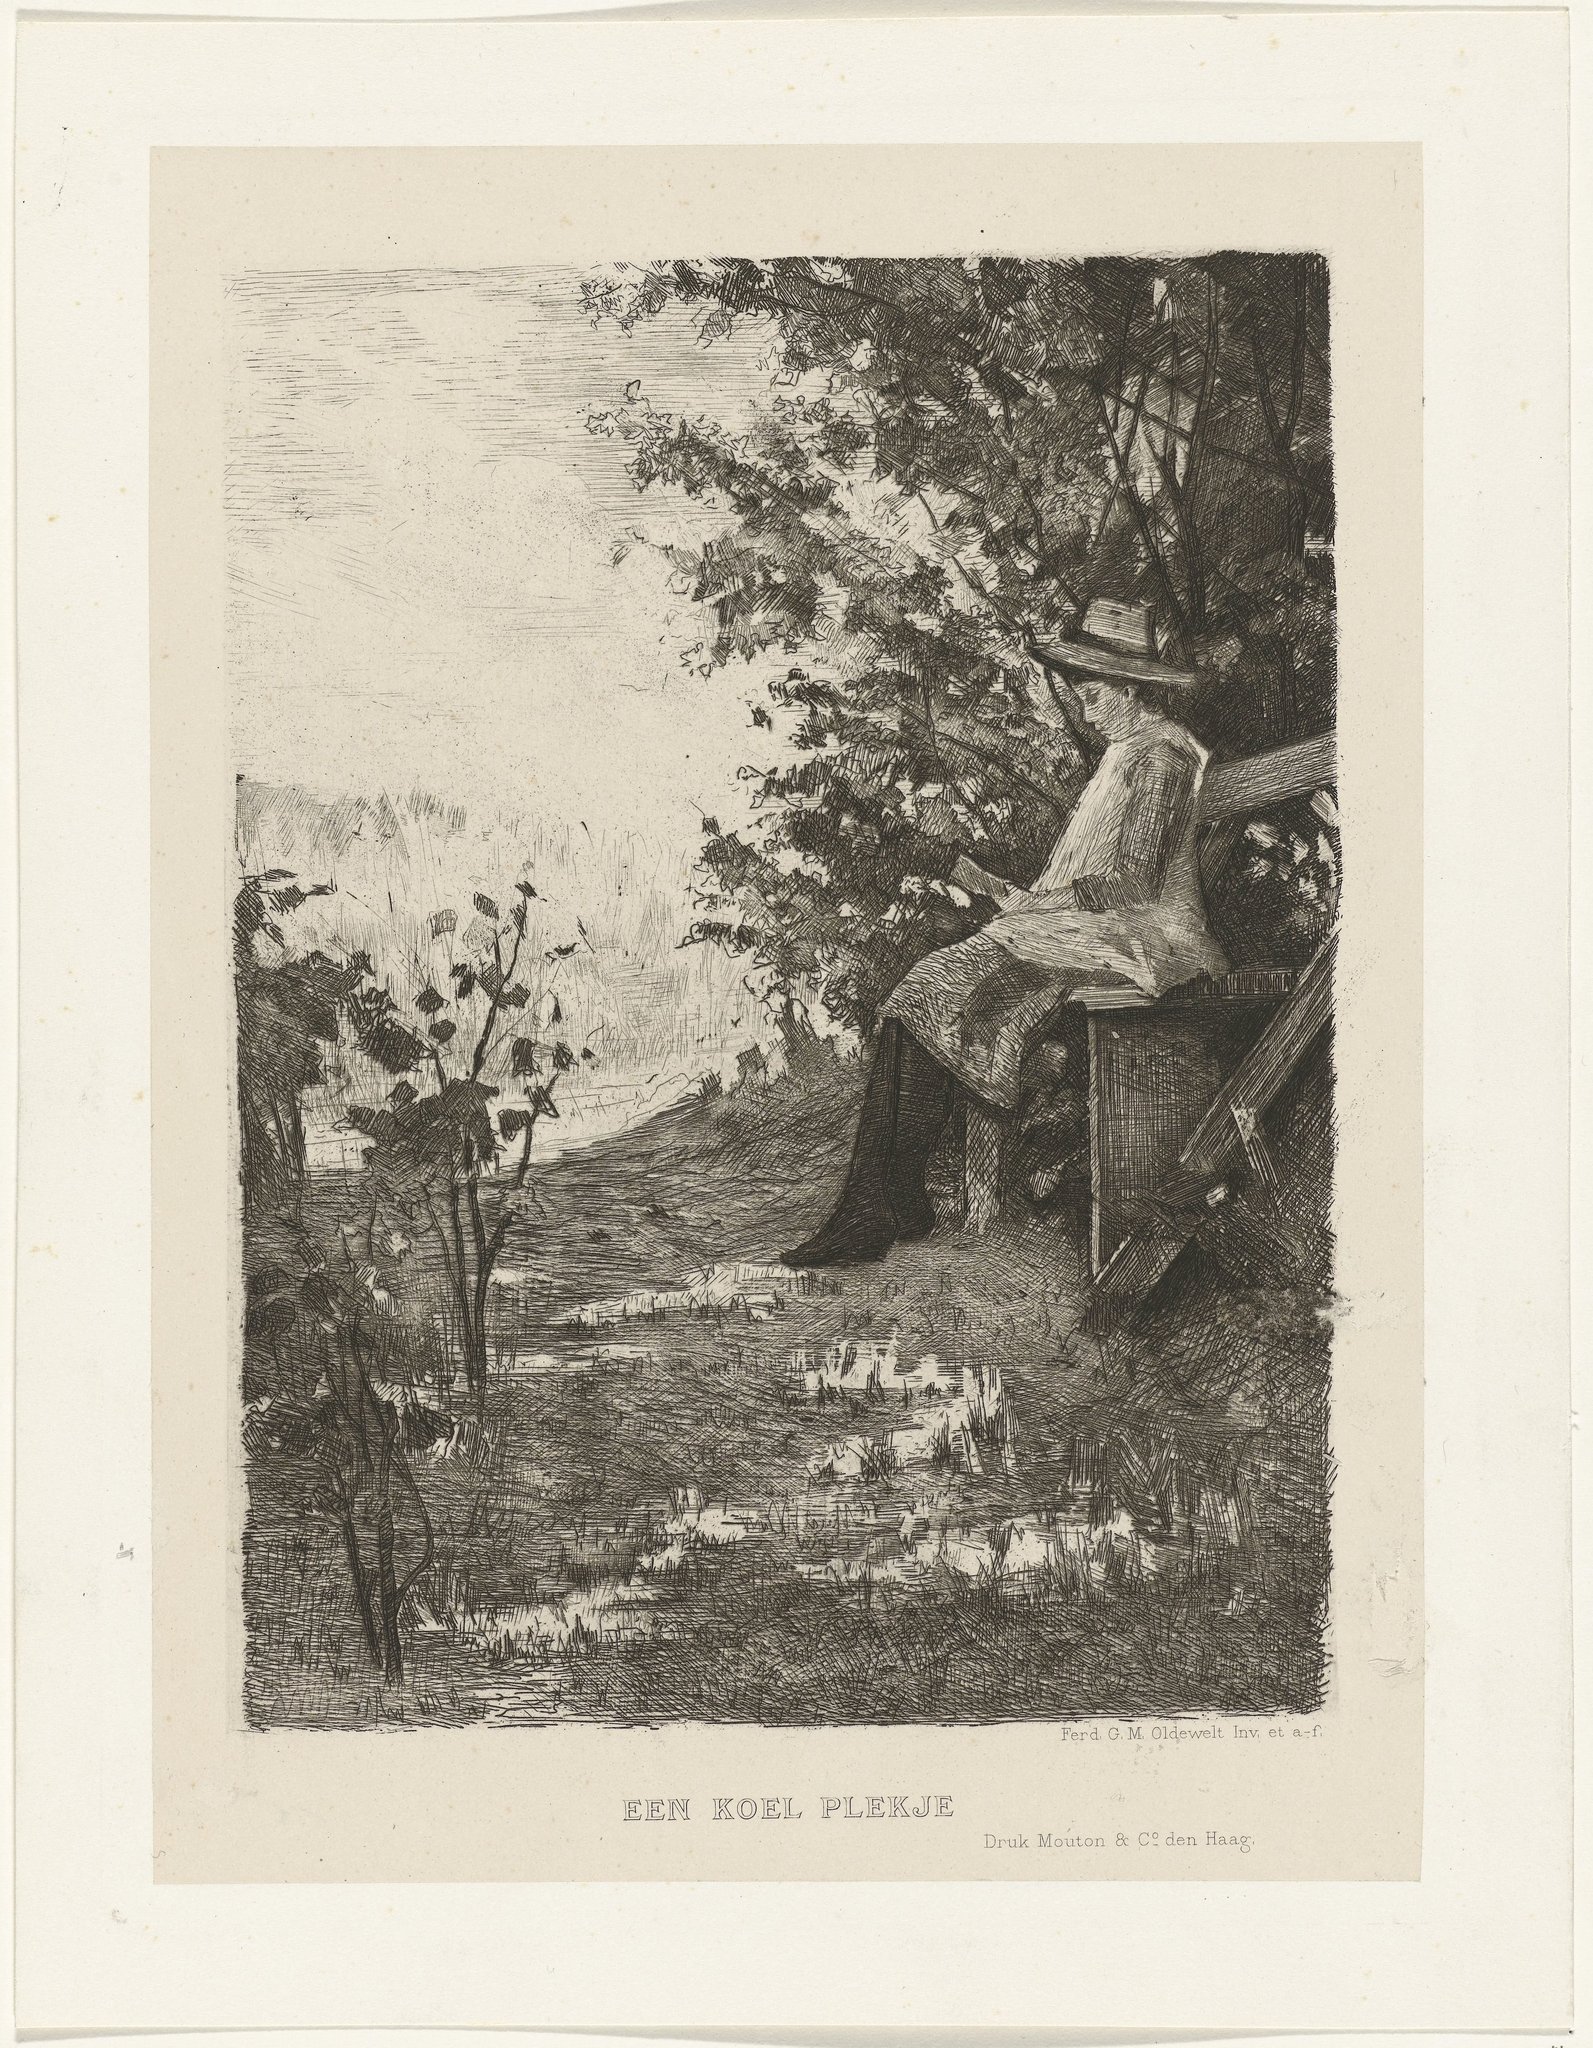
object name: print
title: Een koel plekje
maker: ferdinand oldewelt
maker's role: draughtsman, print maker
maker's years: 1857-1935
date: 1872-1897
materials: paper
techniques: drypoint, etching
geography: the hague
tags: reading, boy (child between toddler and youth)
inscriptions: collector's mark: Lugt 2228